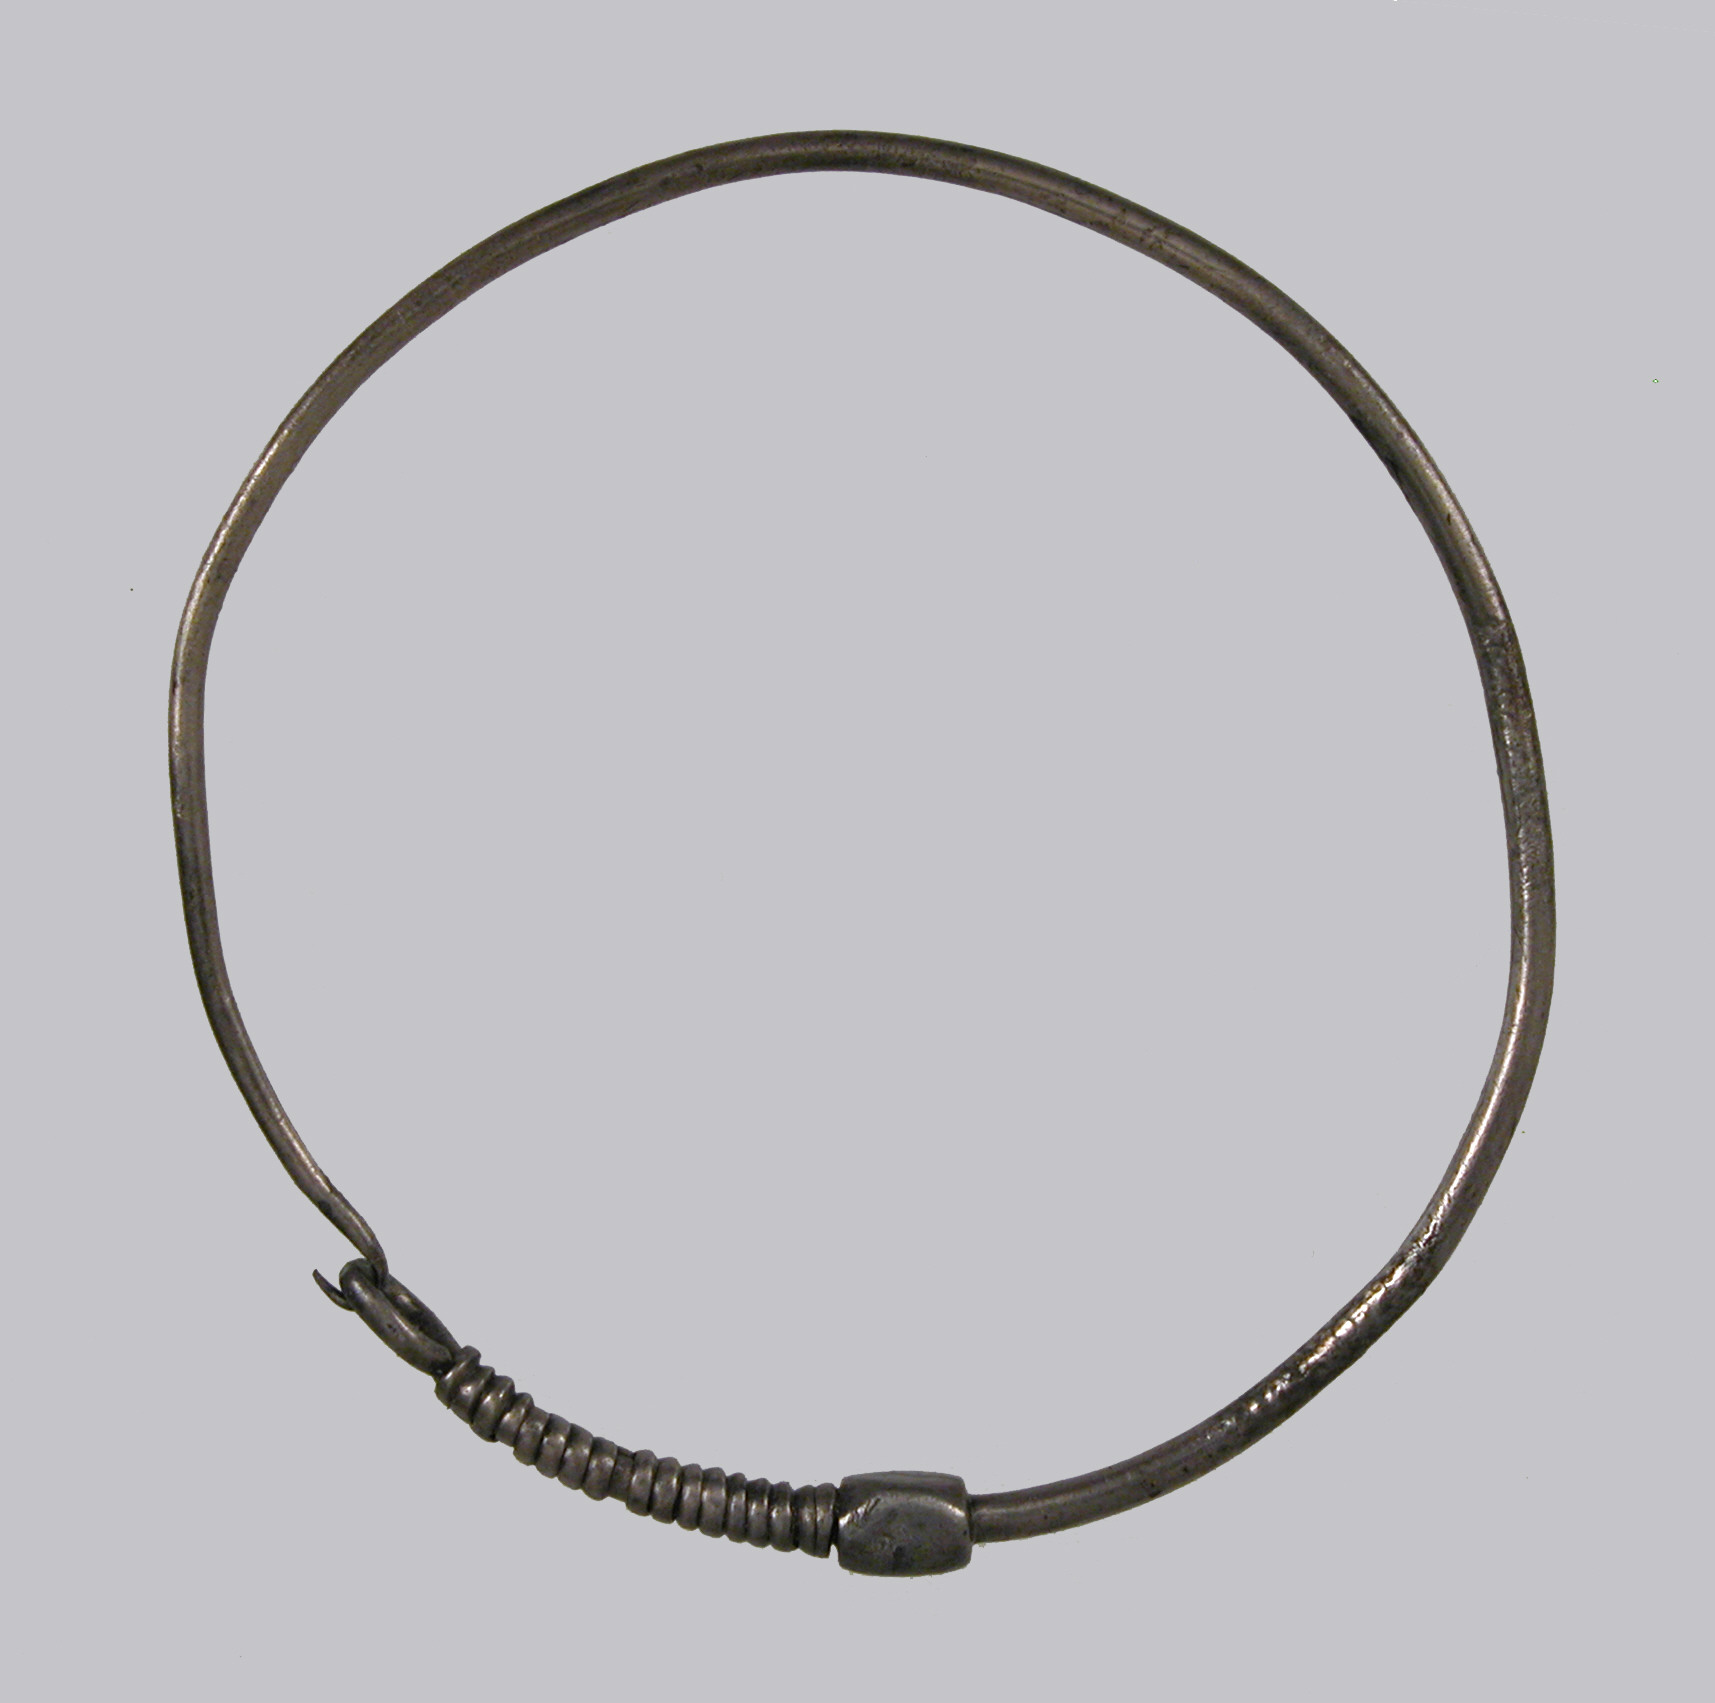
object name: earring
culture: frankish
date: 601-700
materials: silver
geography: germany